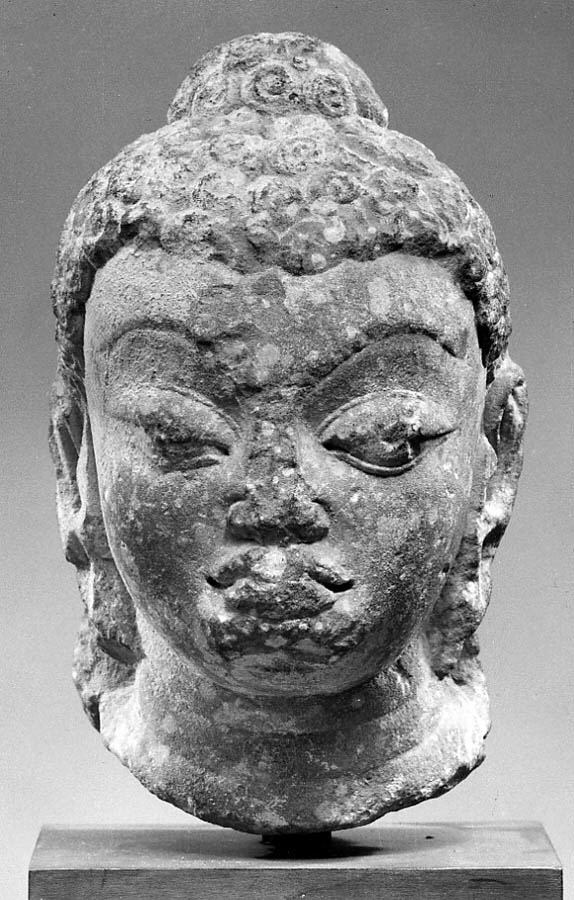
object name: head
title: Head of a Buddha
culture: indian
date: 401-500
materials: stone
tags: gupta,heads,buddhism,buddha